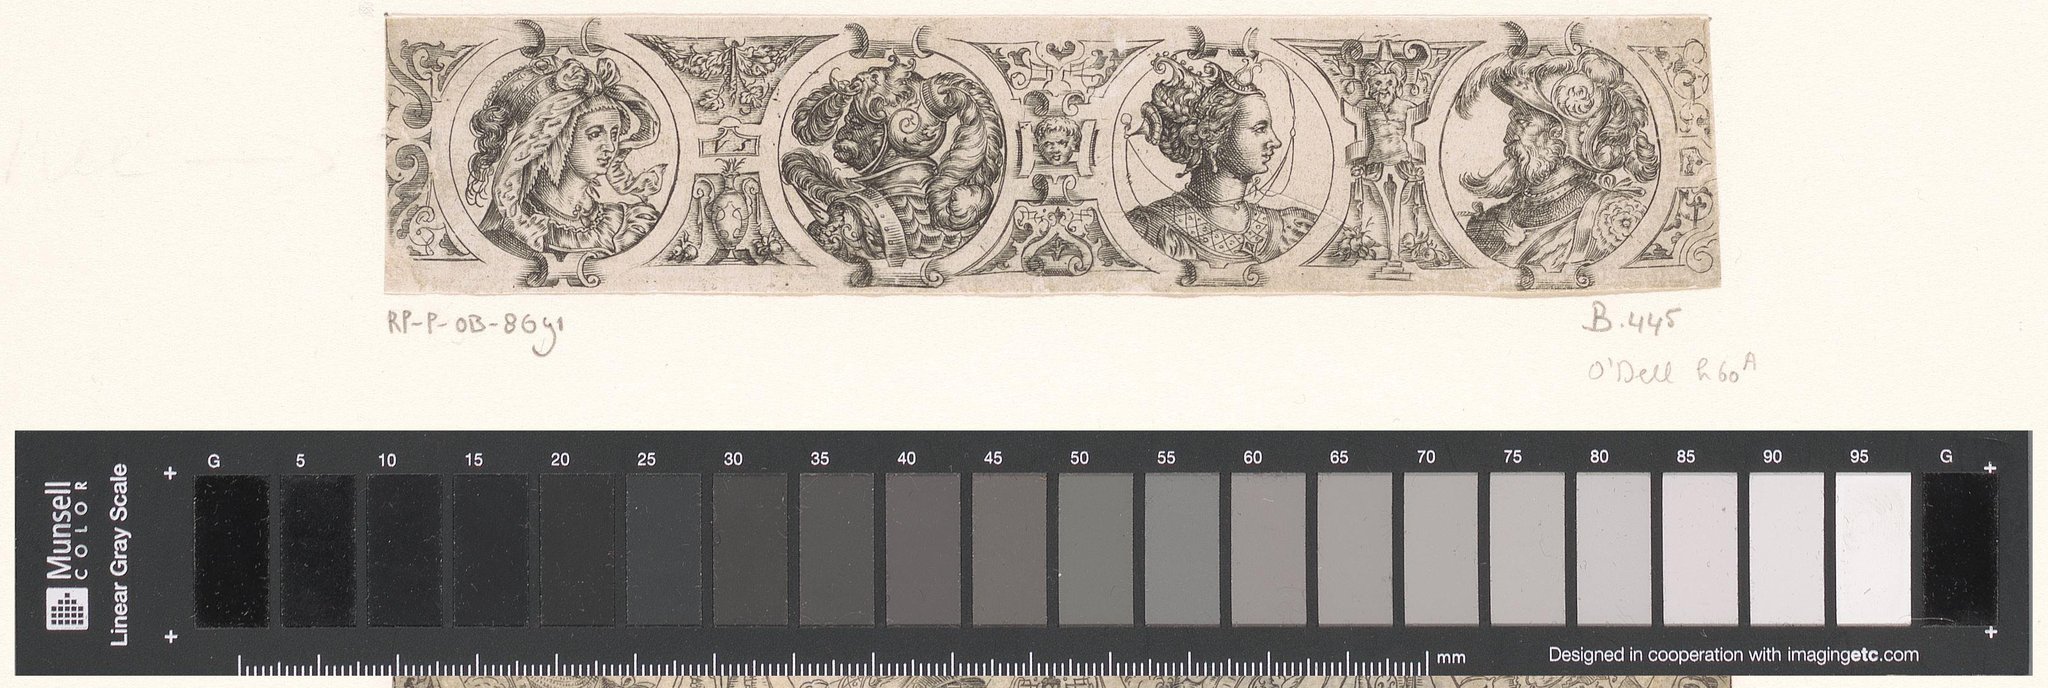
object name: print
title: Fries met vier bustes in medaillons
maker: virgilius solis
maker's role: draughtsman, print maker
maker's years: 1514-1562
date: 1524-1562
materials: paper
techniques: engraving, intaglio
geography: nuremberg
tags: chest, bust, scrollwork, strapwork ~ ornament, head-gear, ornament ~ medallion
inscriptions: collector's mark: Lugt 2228, number: ‘13’